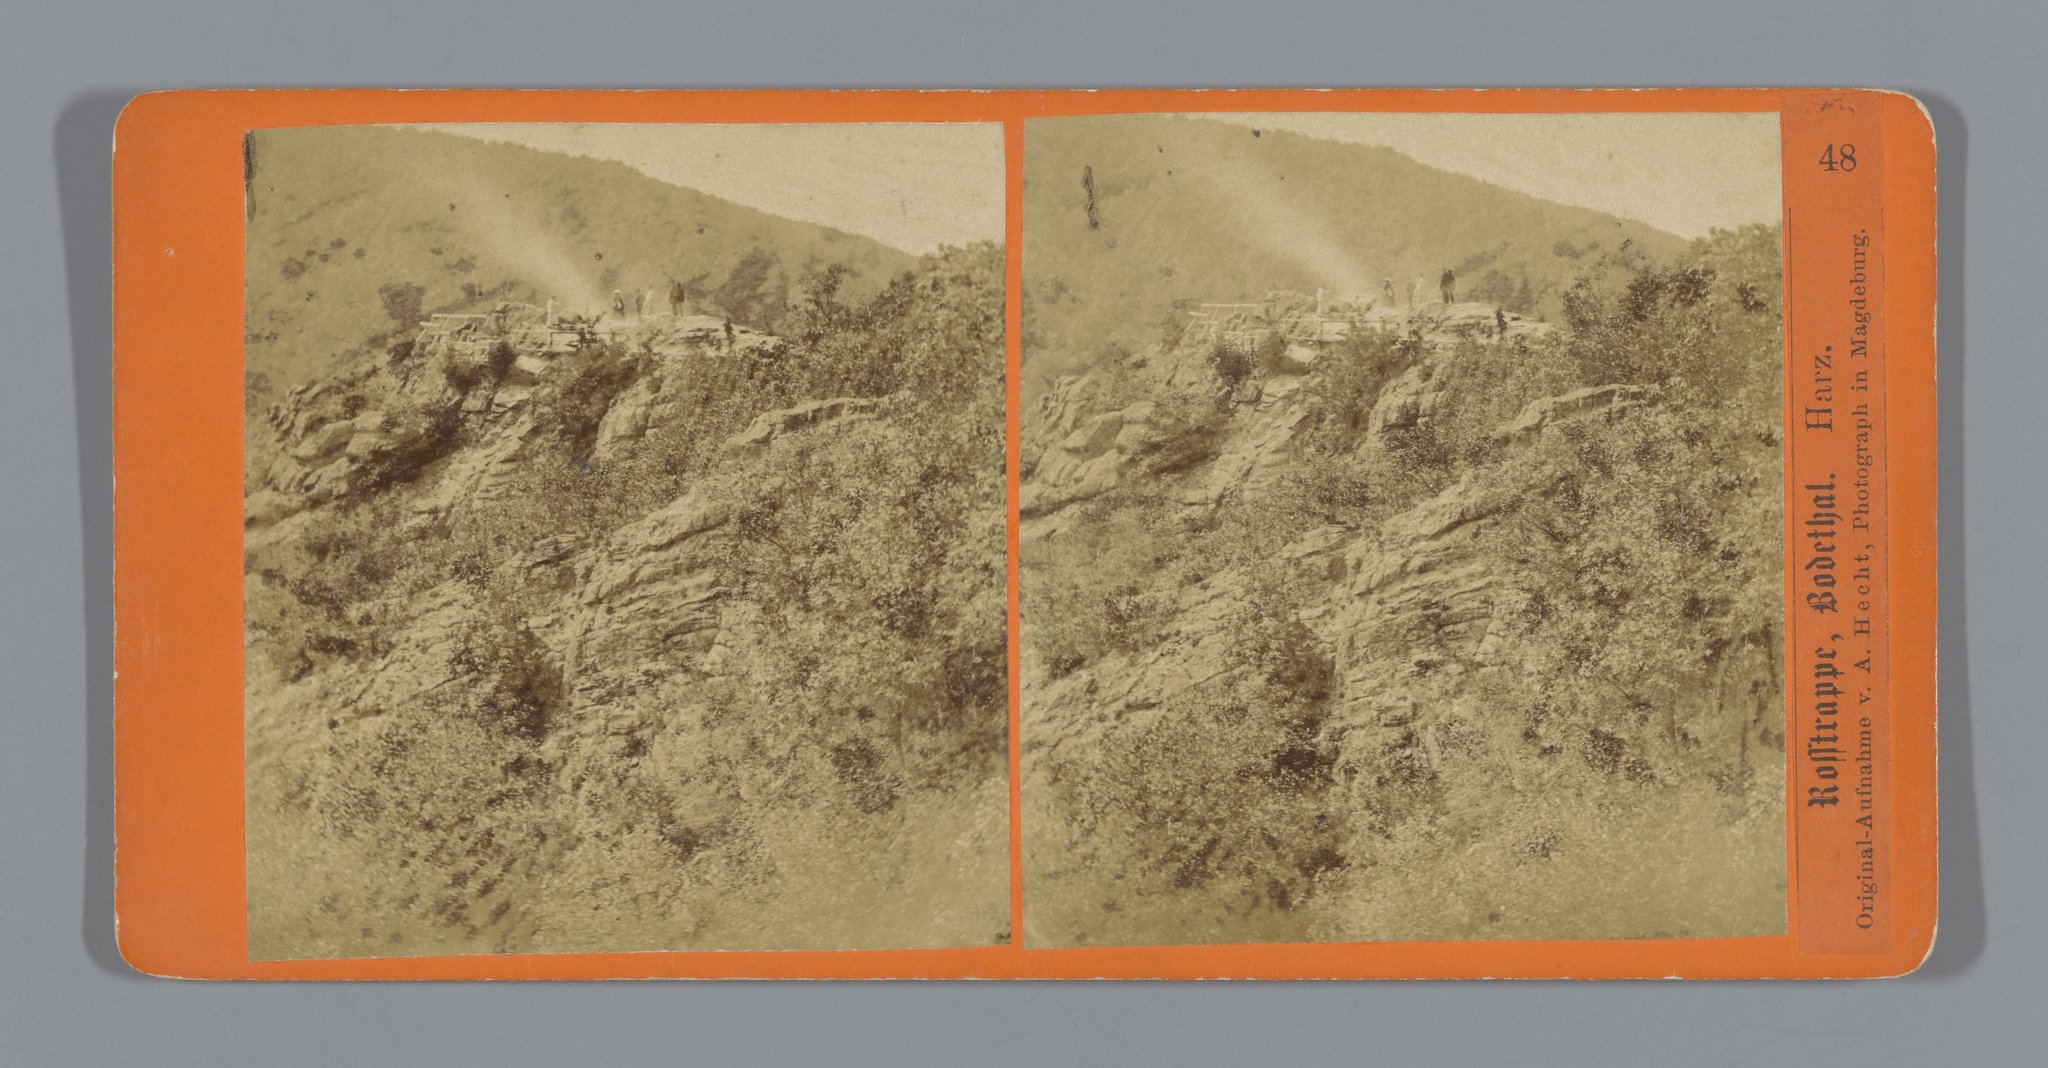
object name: stereograph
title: Rosstrappe, Bodethal. Harz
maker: adolph hecht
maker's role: fotograaf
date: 1855-1880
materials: cardboard, photographic support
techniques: albumen print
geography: harz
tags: rock-formations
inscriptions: number: ‘48’